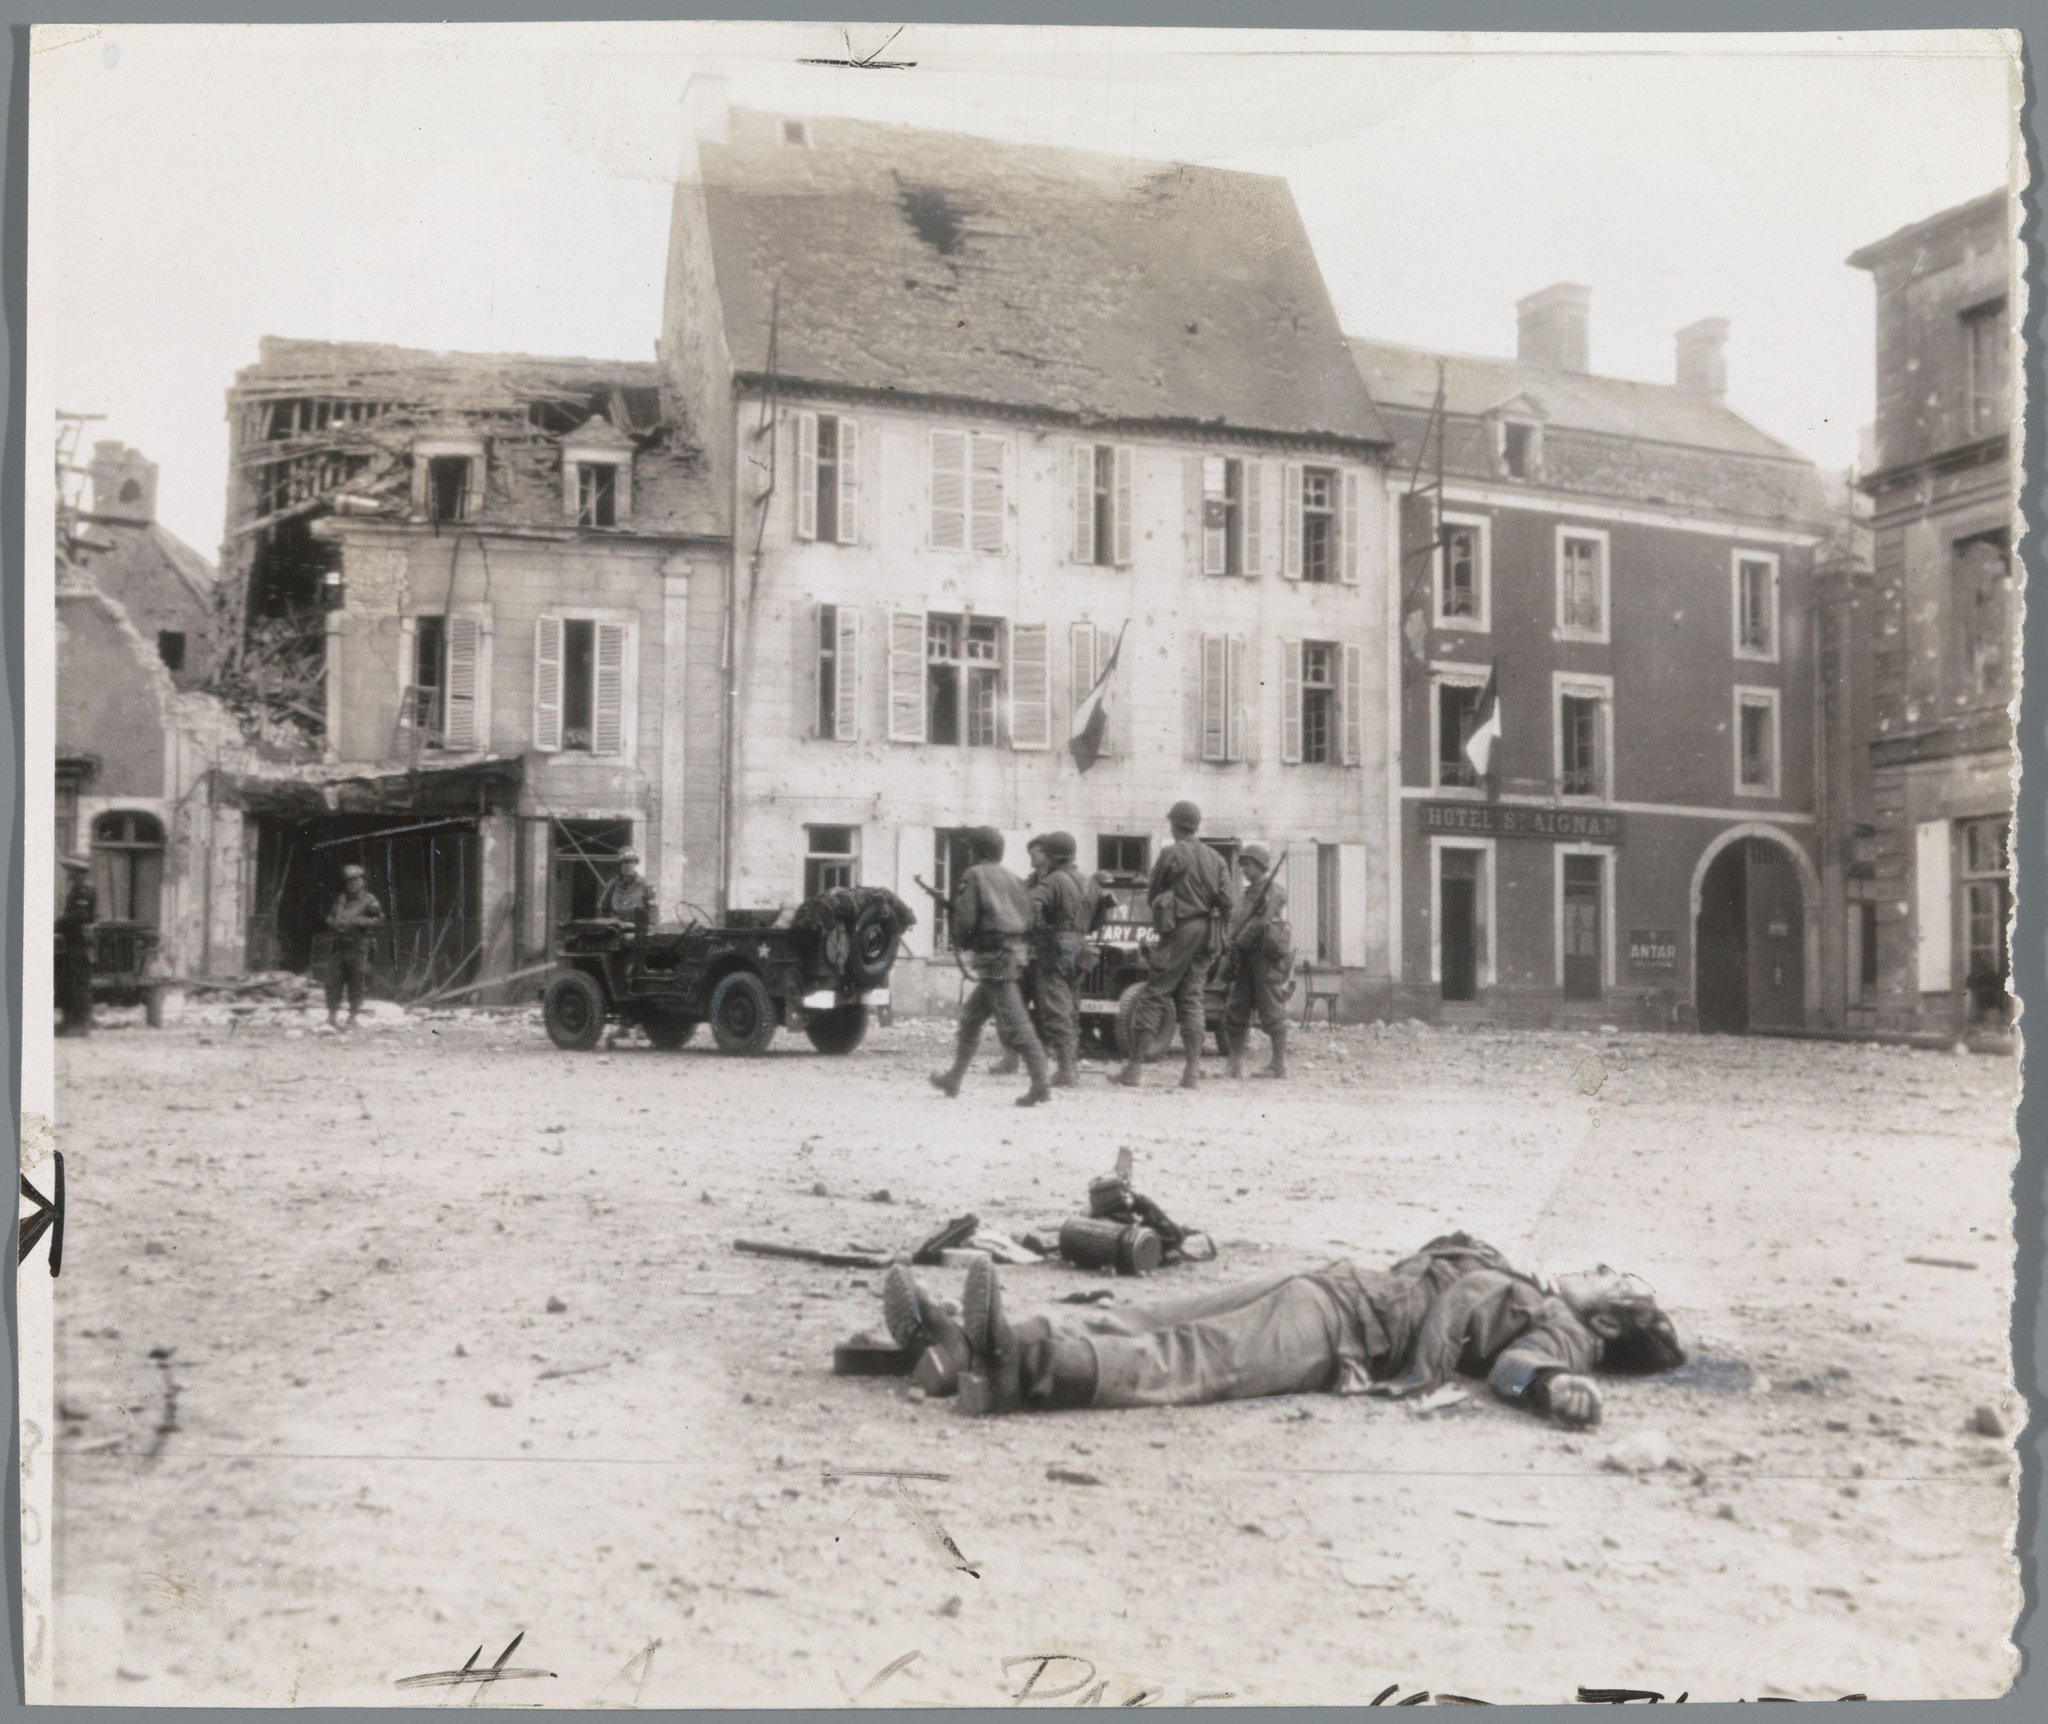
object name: photograph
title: Yanks take over war-battered French town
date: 1944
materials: paper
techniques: gelatin silver print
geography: france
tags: battle, fighting in general, france